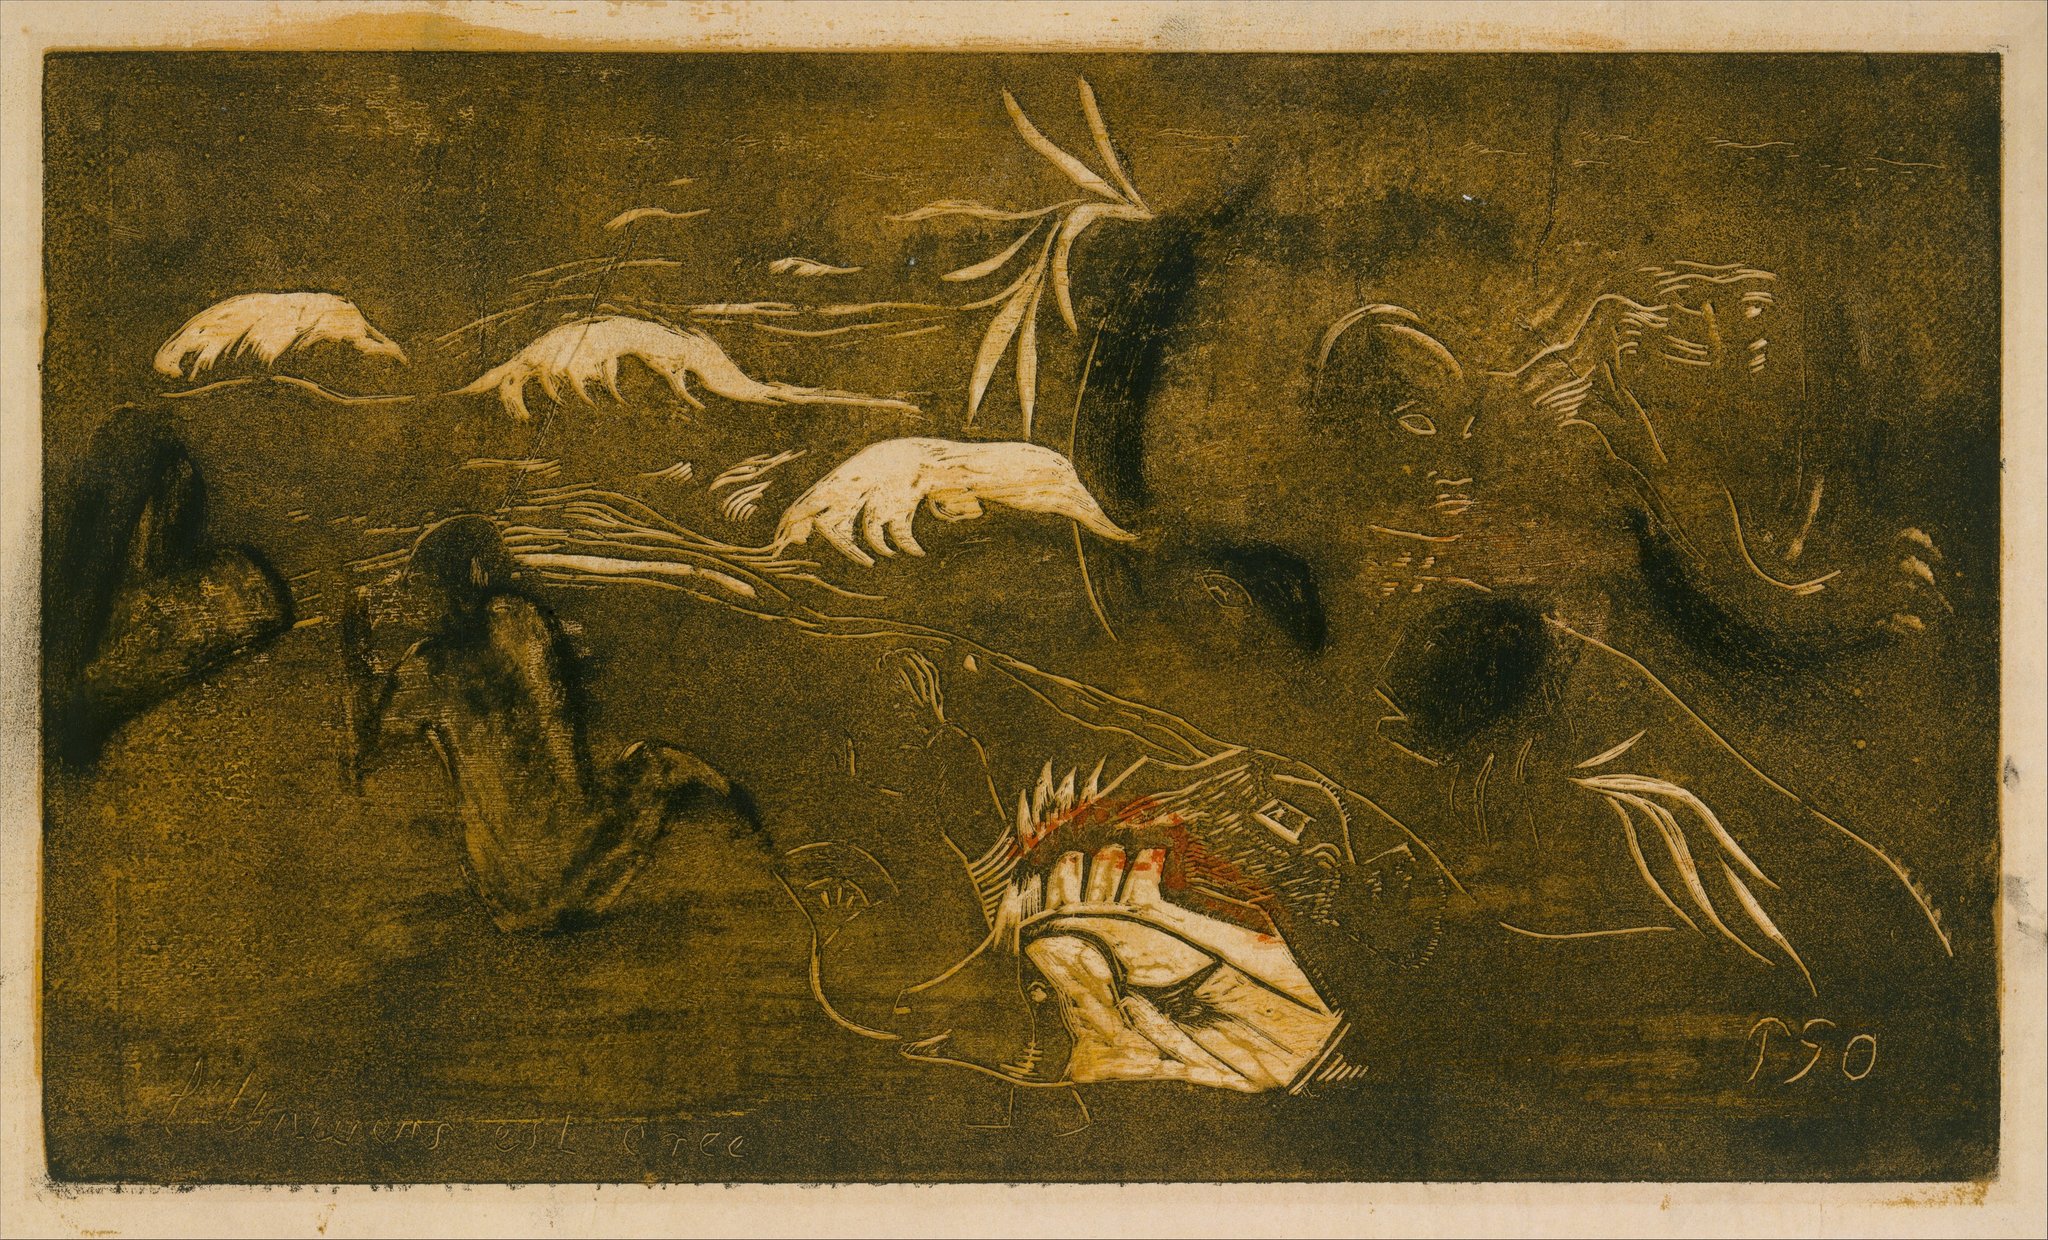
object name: print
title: The Universe Is Created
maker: paul gauguin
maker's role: artist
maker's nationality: french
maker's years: 1848-1903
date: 1893-1894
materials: paper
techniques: printing, woodcut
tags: human figures,leaves